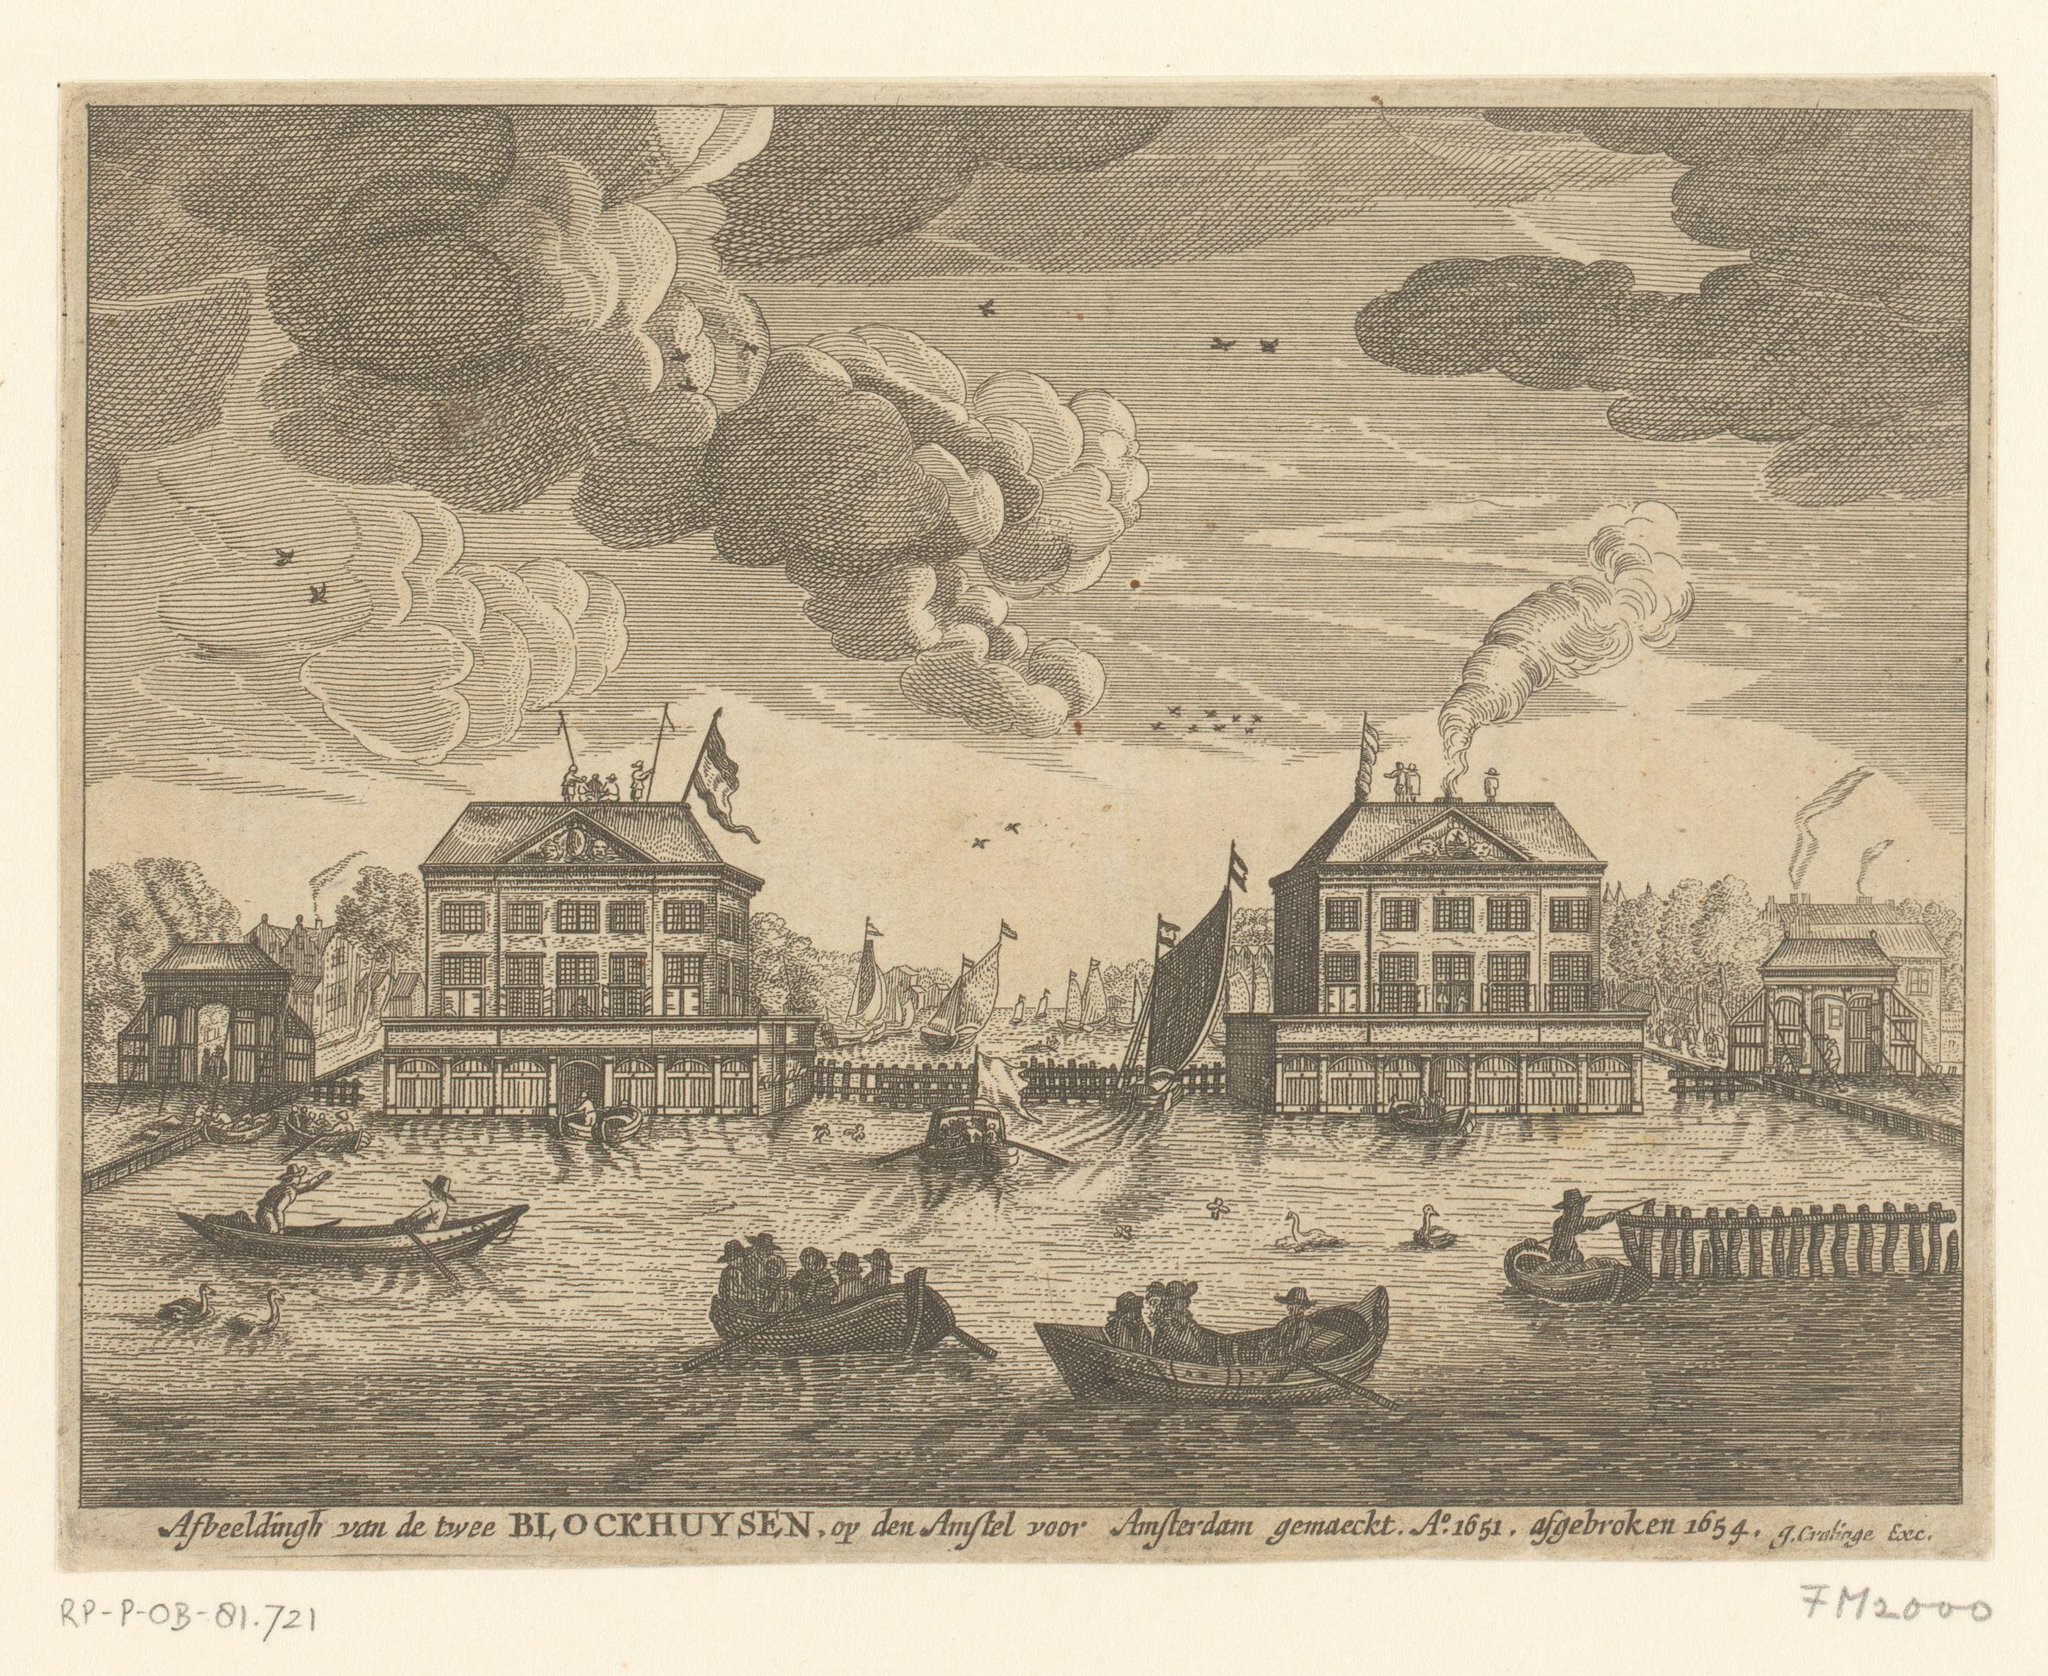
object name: print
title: Afbeeldingh van de twee Blockhuysen, op den Amstel voor Amsterdam gemaeckt Ao 1651, afgebroken 1654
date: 1655-1673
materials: paper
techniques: etching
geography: northern netherlands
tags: fortress, amsterdam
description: De twee Blokhuizen in de Amstel buiten Amsterdam, gebouwd in 1651 ter verdediging van de stad na de mislukte aanslag door Willem II op Amsterdam 30 juli 1650. Links en rechts van de Blokhuizen twee hameien, de voorlopers van de latere stadspoorten. Op het water verschillende bootjes.